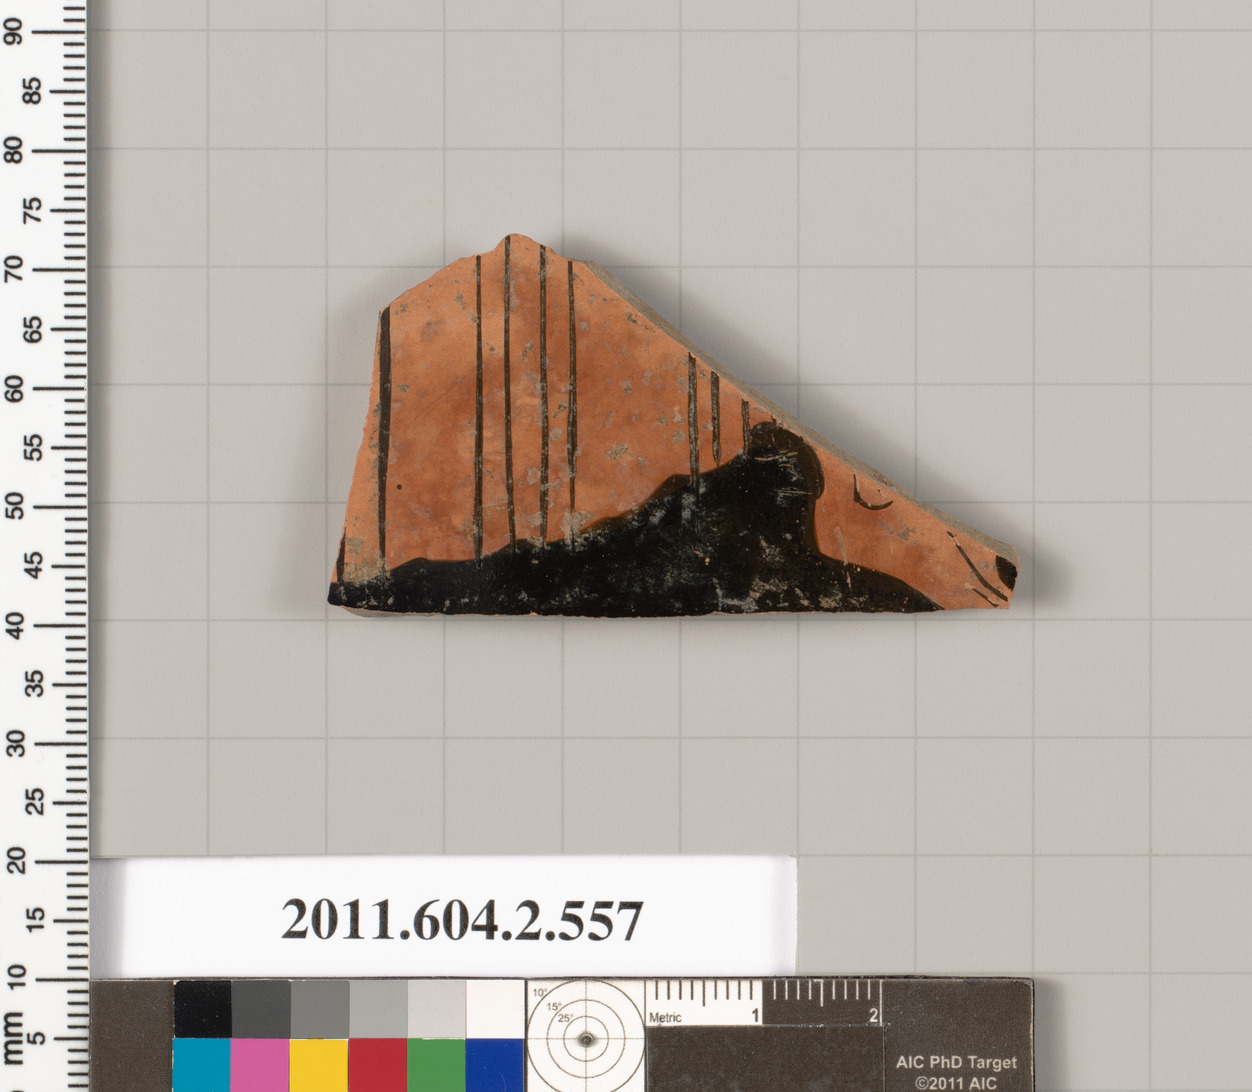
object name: column krater fragment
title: Terracotta fragment of a column-krater (bowl for mixing wine and water)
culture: greek, attic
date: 460-450 BCE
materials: terracotta